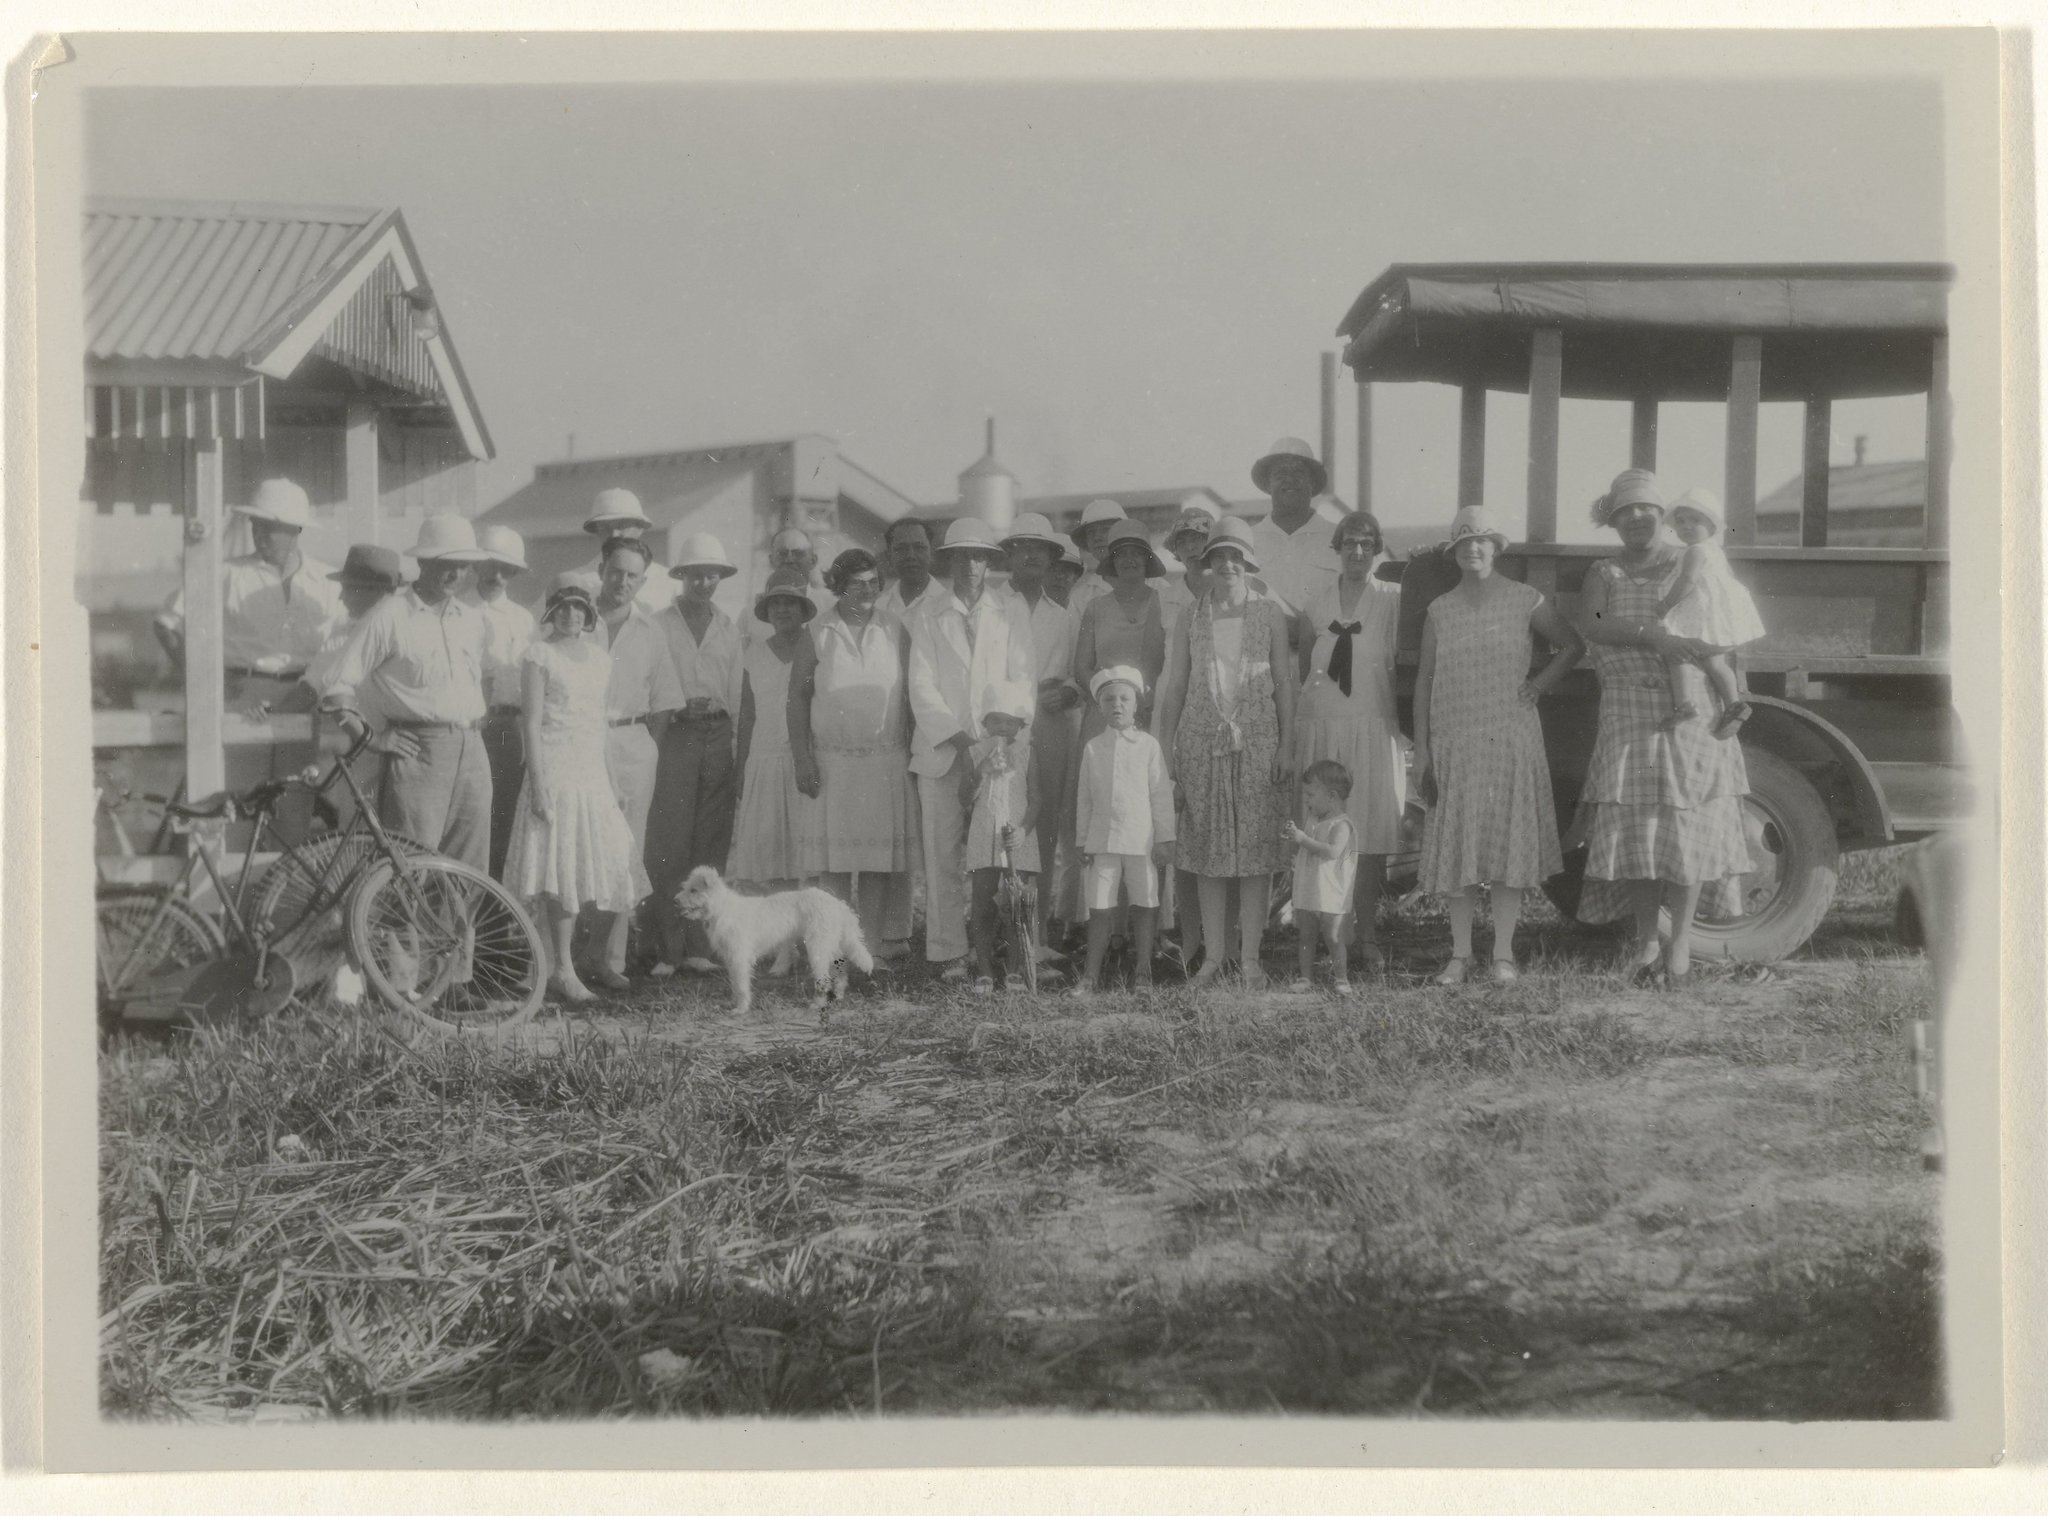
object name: photograph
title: Groepsportret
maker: Anonymous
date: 1929-1930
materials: photographic support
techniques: photography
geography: suriname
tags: albina, moengo